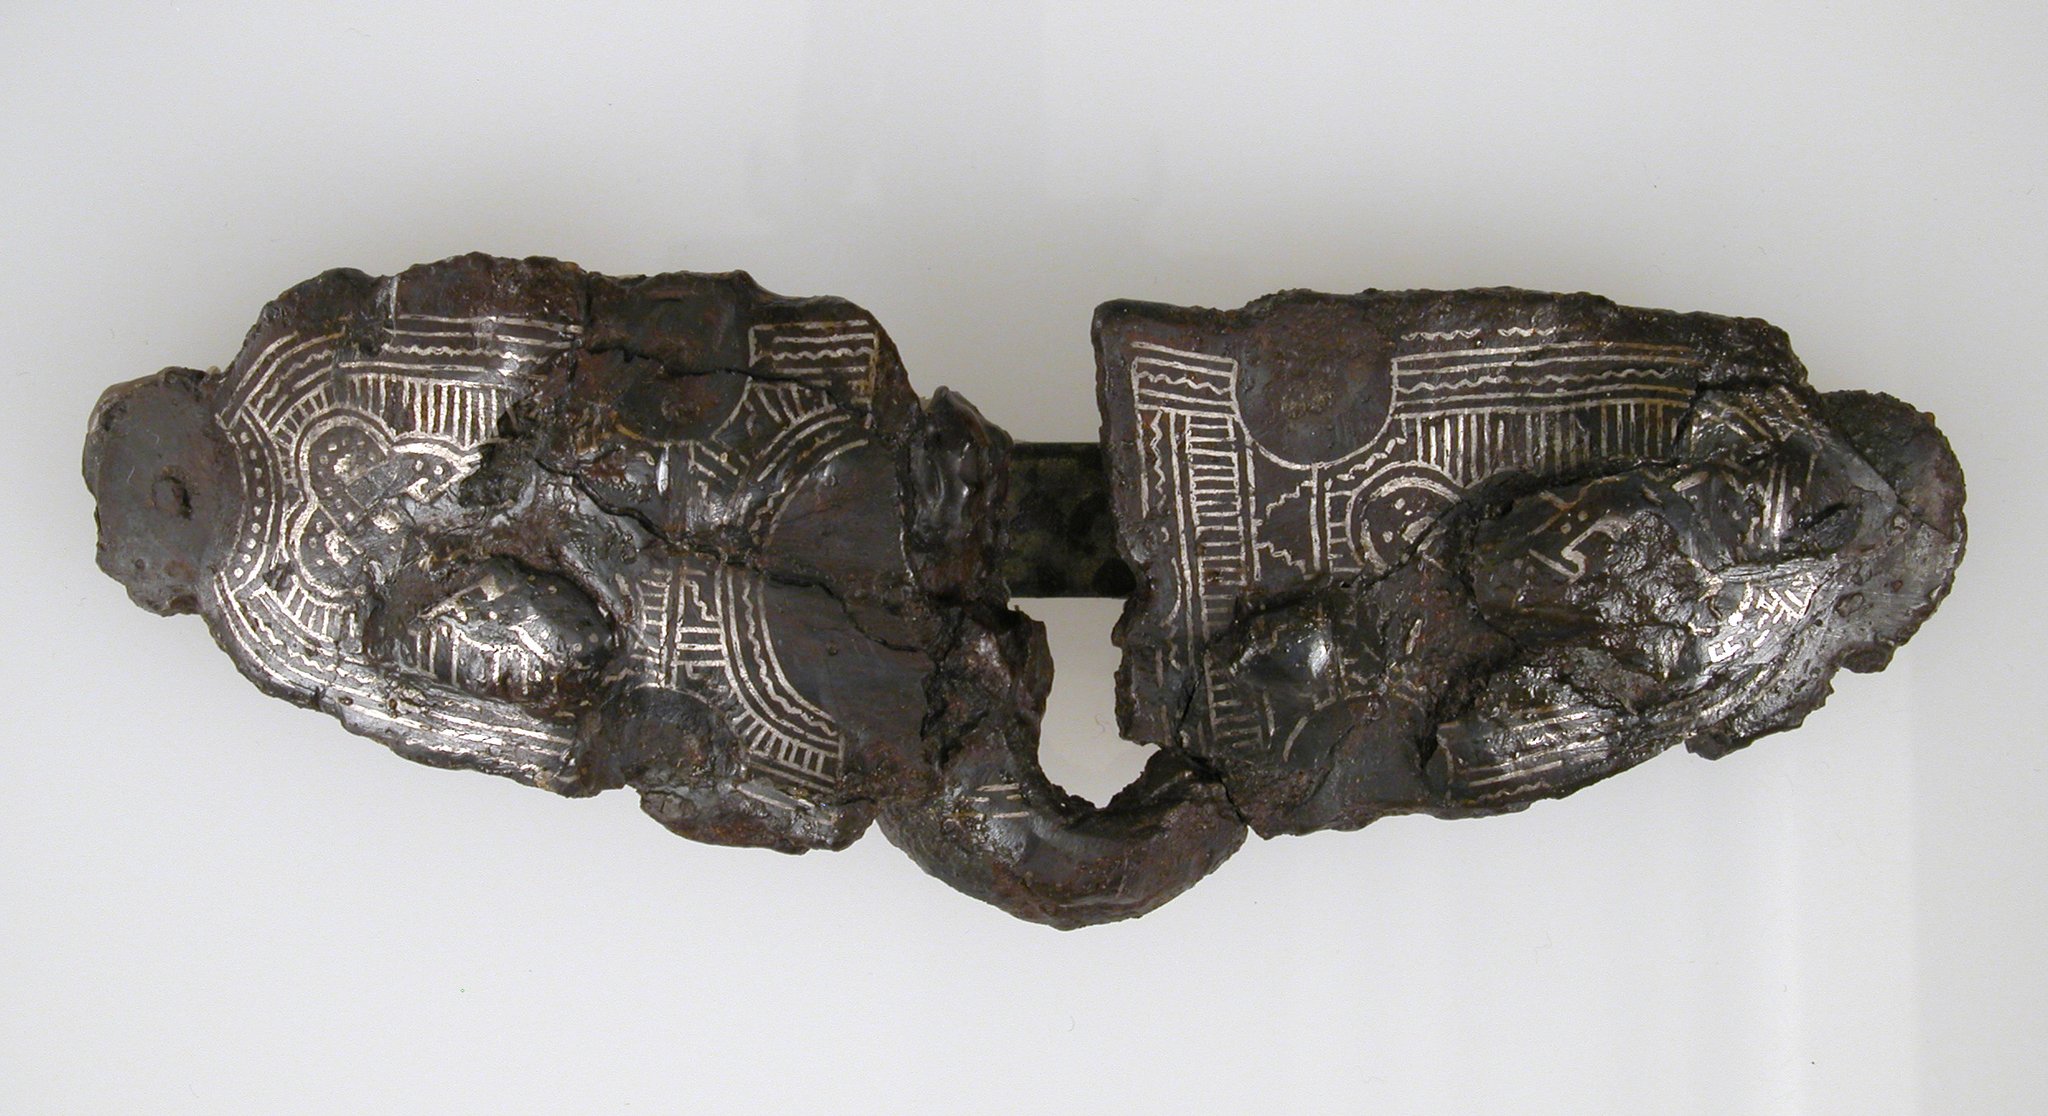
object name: buckle plate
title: Belt Buckle and Counter Plate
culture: frankish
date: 601-700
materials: iron, silver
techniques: inlay